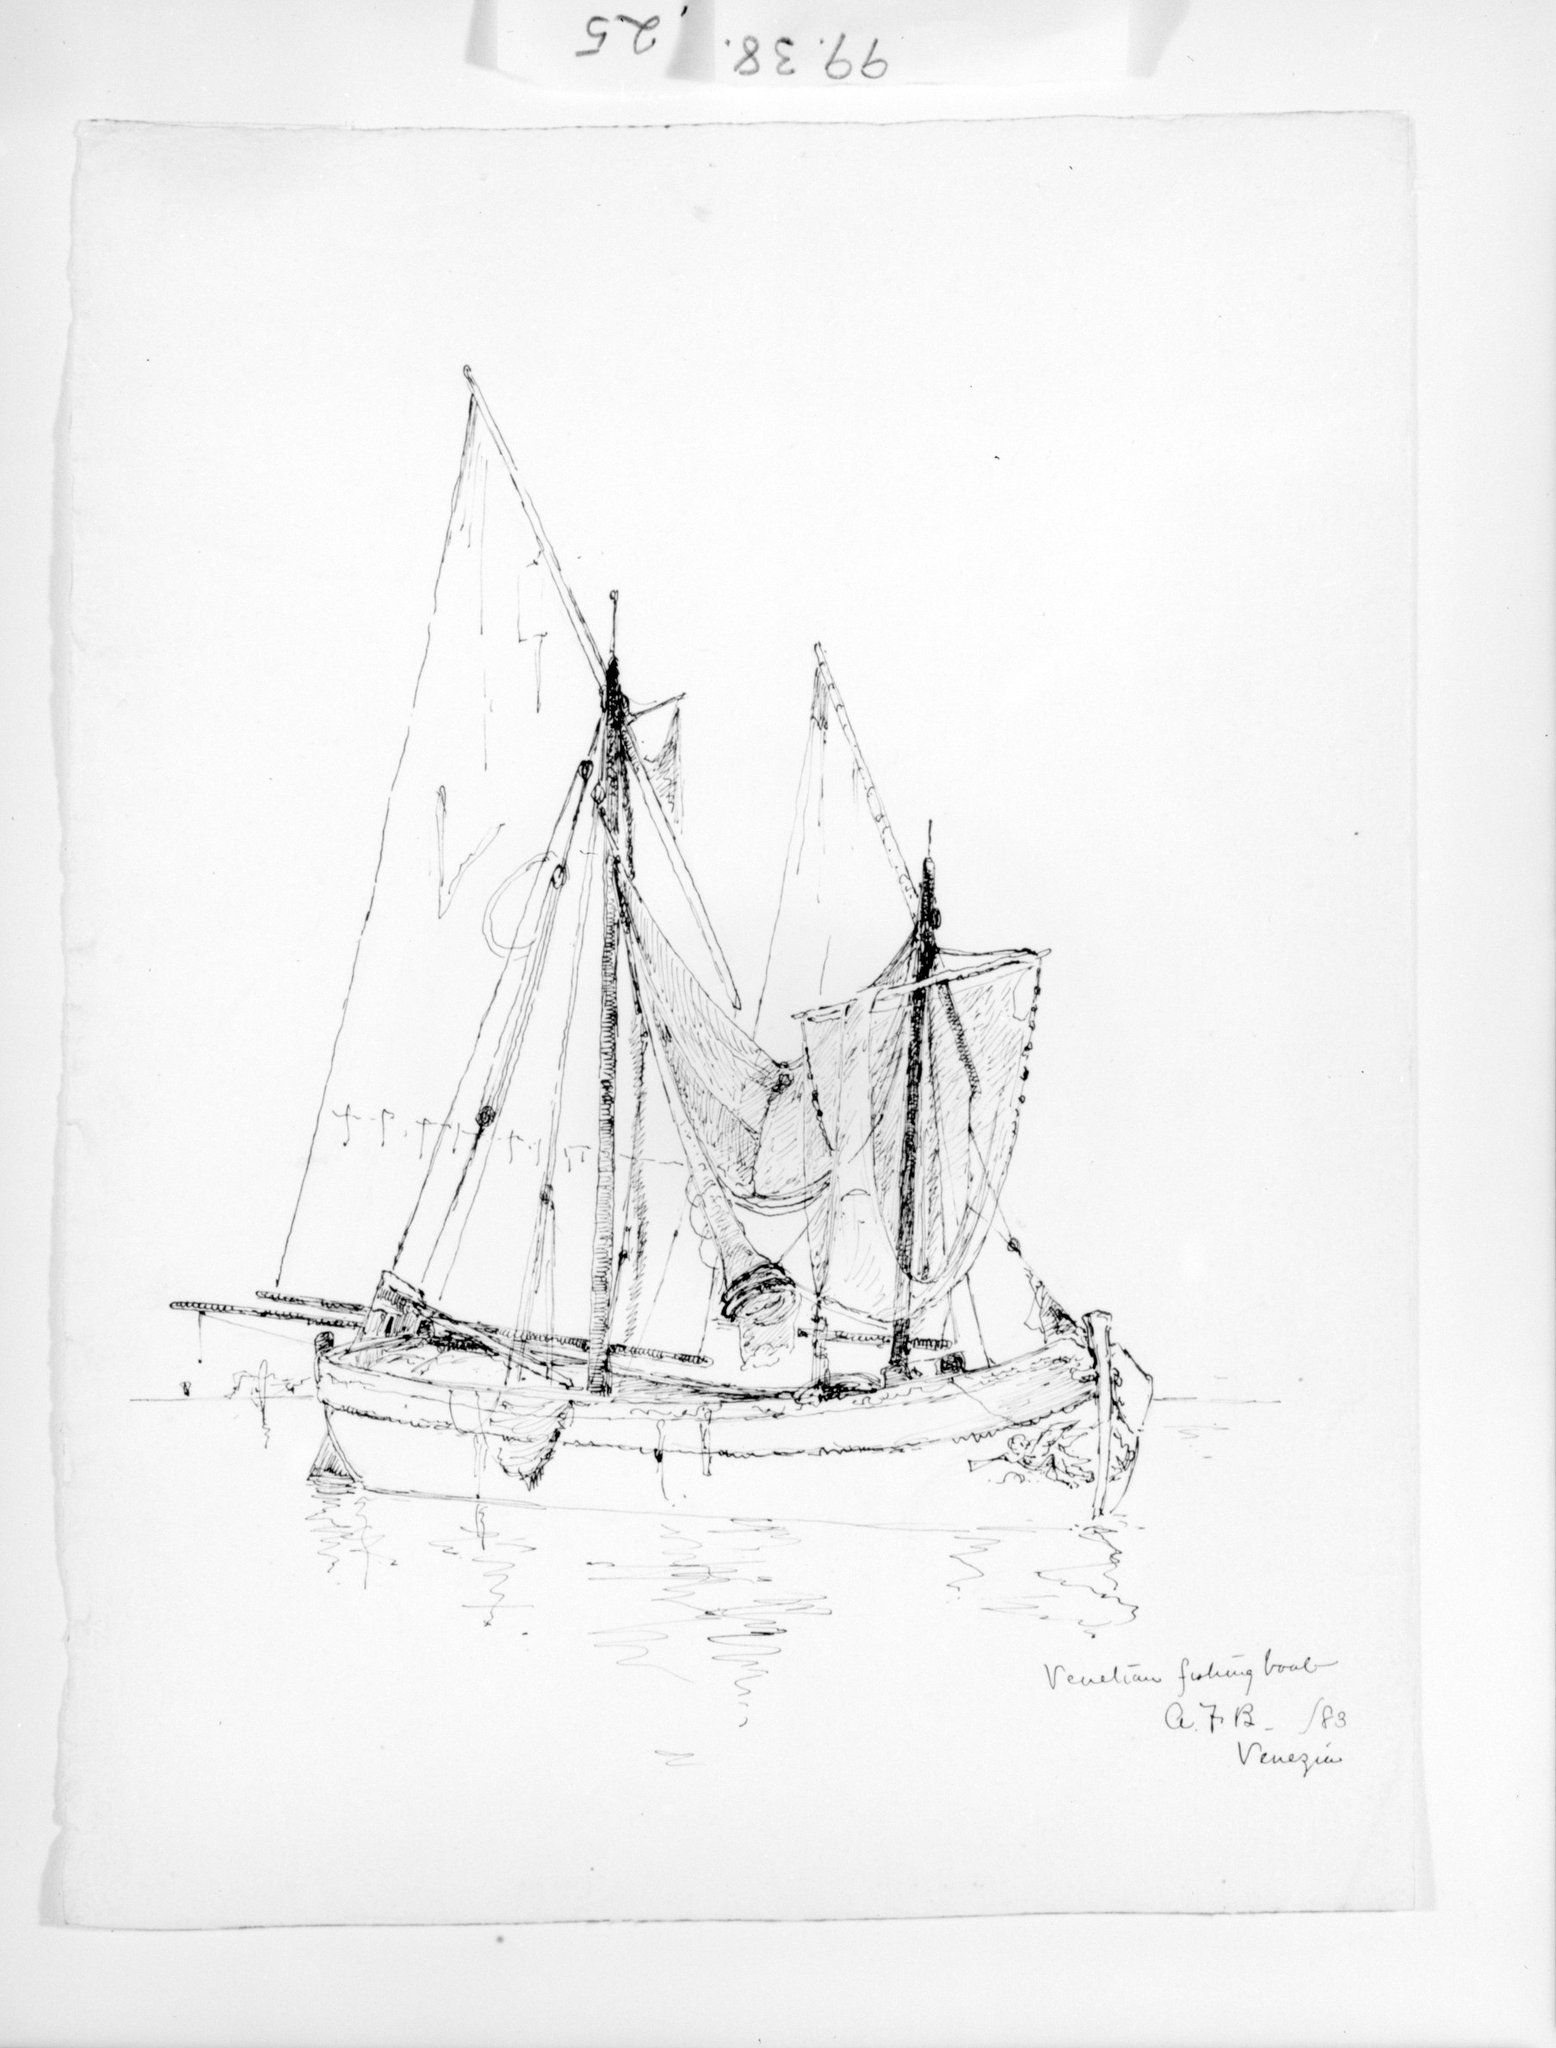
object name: drawing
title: Venetian Fishing Boat, Venice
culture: american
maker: andrew fisher bunner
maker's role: artist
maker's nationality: american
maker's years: 1841-1897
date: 1883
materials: graphite, ink, paper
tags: boats,venice